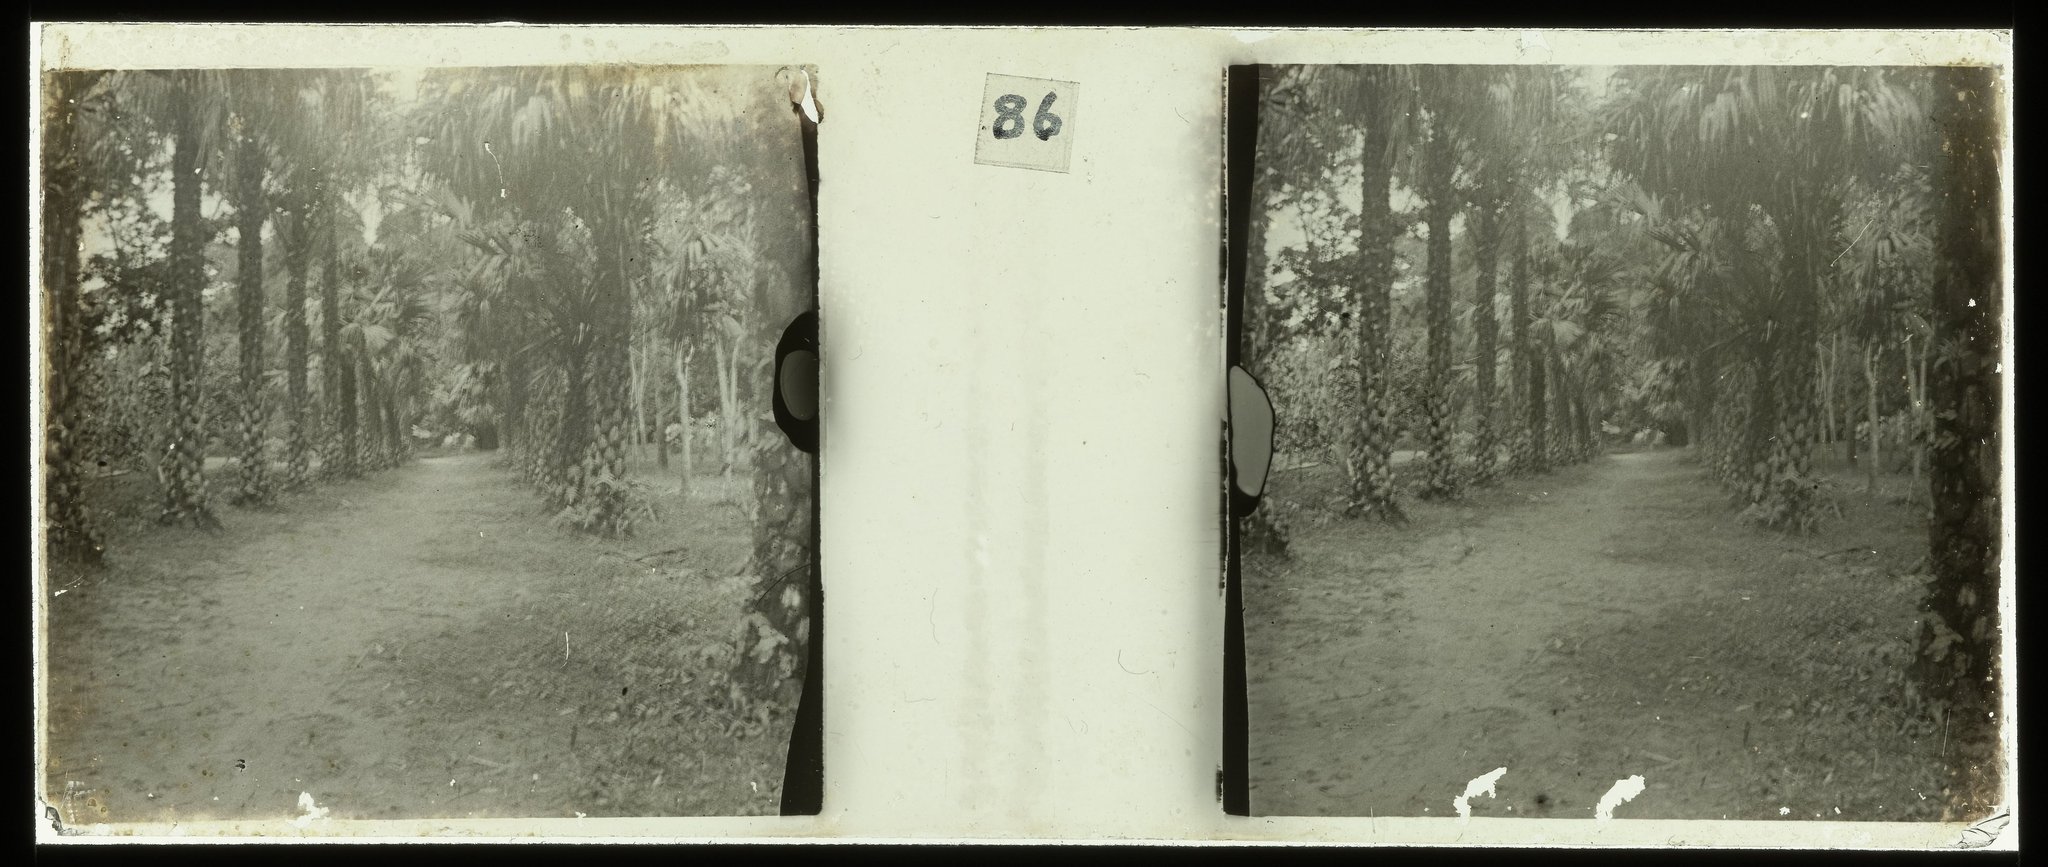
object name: stereograph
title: Palmentuin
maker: theodoor brouwers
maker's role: amateurfotograaf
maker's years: 1874-1932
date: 1913-1930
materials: glass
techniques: photography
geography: suriname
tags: amsterdam, theodoor brouwers, suriname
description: In de periode 1911-1932 woonde op plantage Accaribo in Suriname de familie Brouwers van wie de foto's afkomstig zijn. Rond 1910 vond Theodoor Brouwers werk op plantage Accaribo. In 1929 werd hij eigenaar van de plantage. Op Accaribo werden in zijn tijd bananen geproduceerd en wat koffie.